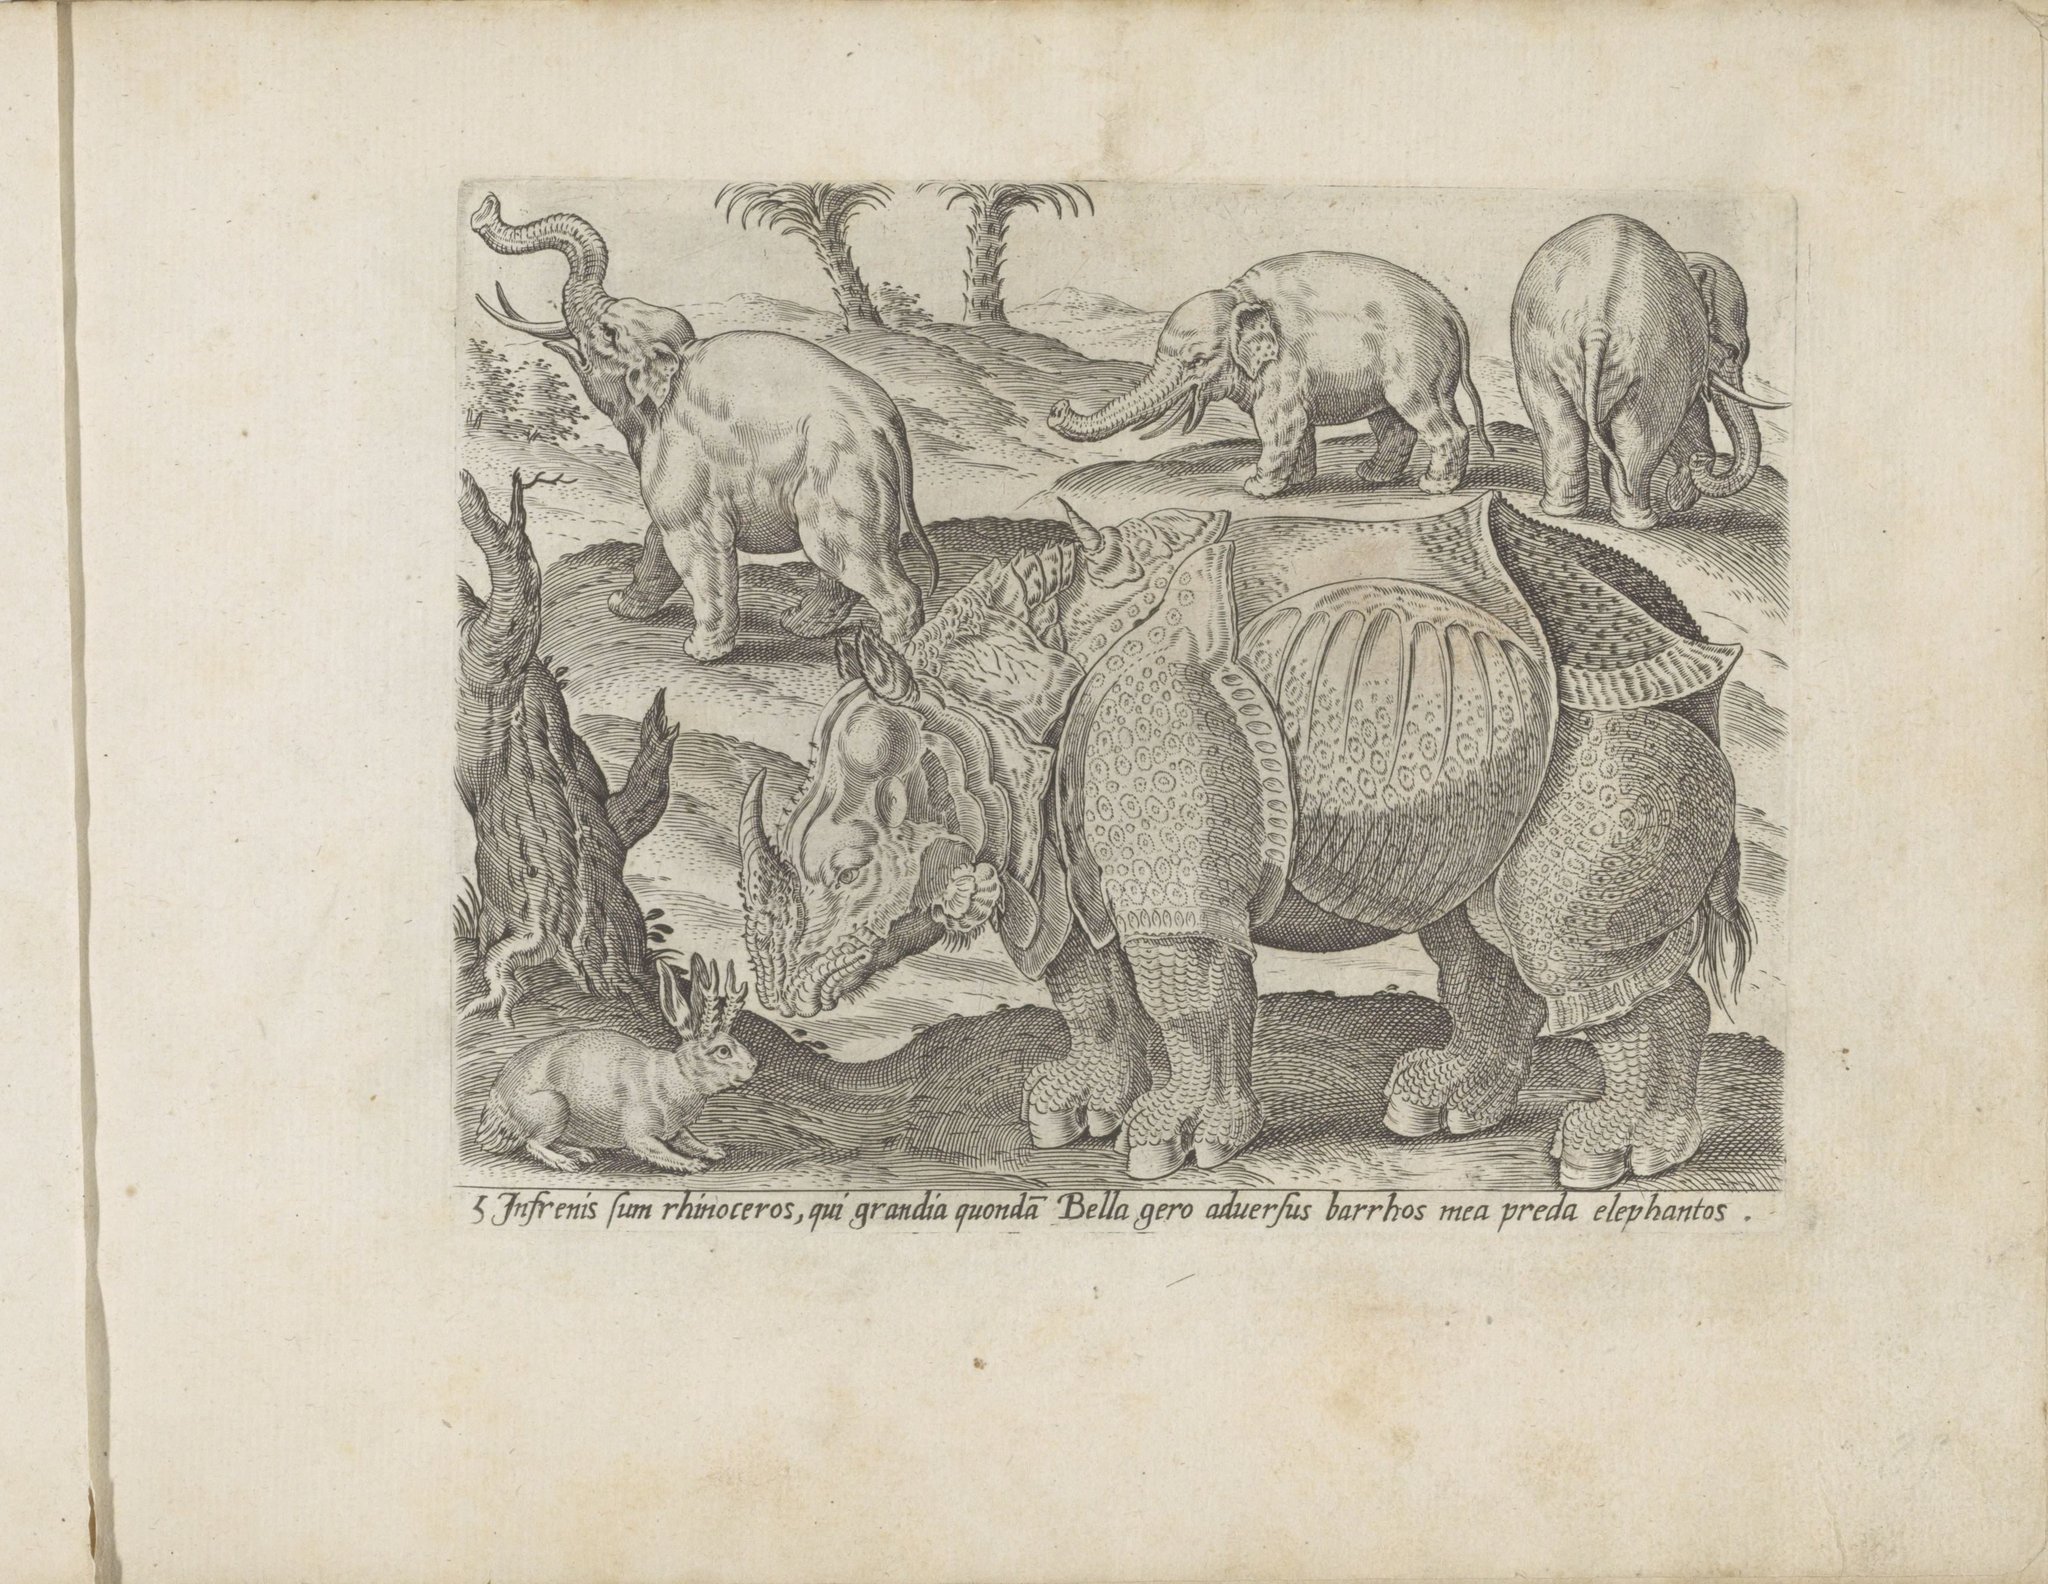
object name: print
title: Neushoorn en drie olifanten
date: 1581-1600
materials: paper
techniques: engraving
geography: netherlands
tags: hoofed animals: rhinoceros, trunked animals: elephant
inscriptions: inscription: ‘5: Infreris sum rhinoceros, qui grandia quonda. Bella gero adversus barrhos mea preda elephantos.’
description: Blad met rhinoceros (neushoorn), staand tegenover een soort konijn met hoorntjes. Op de achtergrond drie olifanten. Onderaan in de marge een verklarende tekst in het Latijn. Prent maakt deel uit van een album.